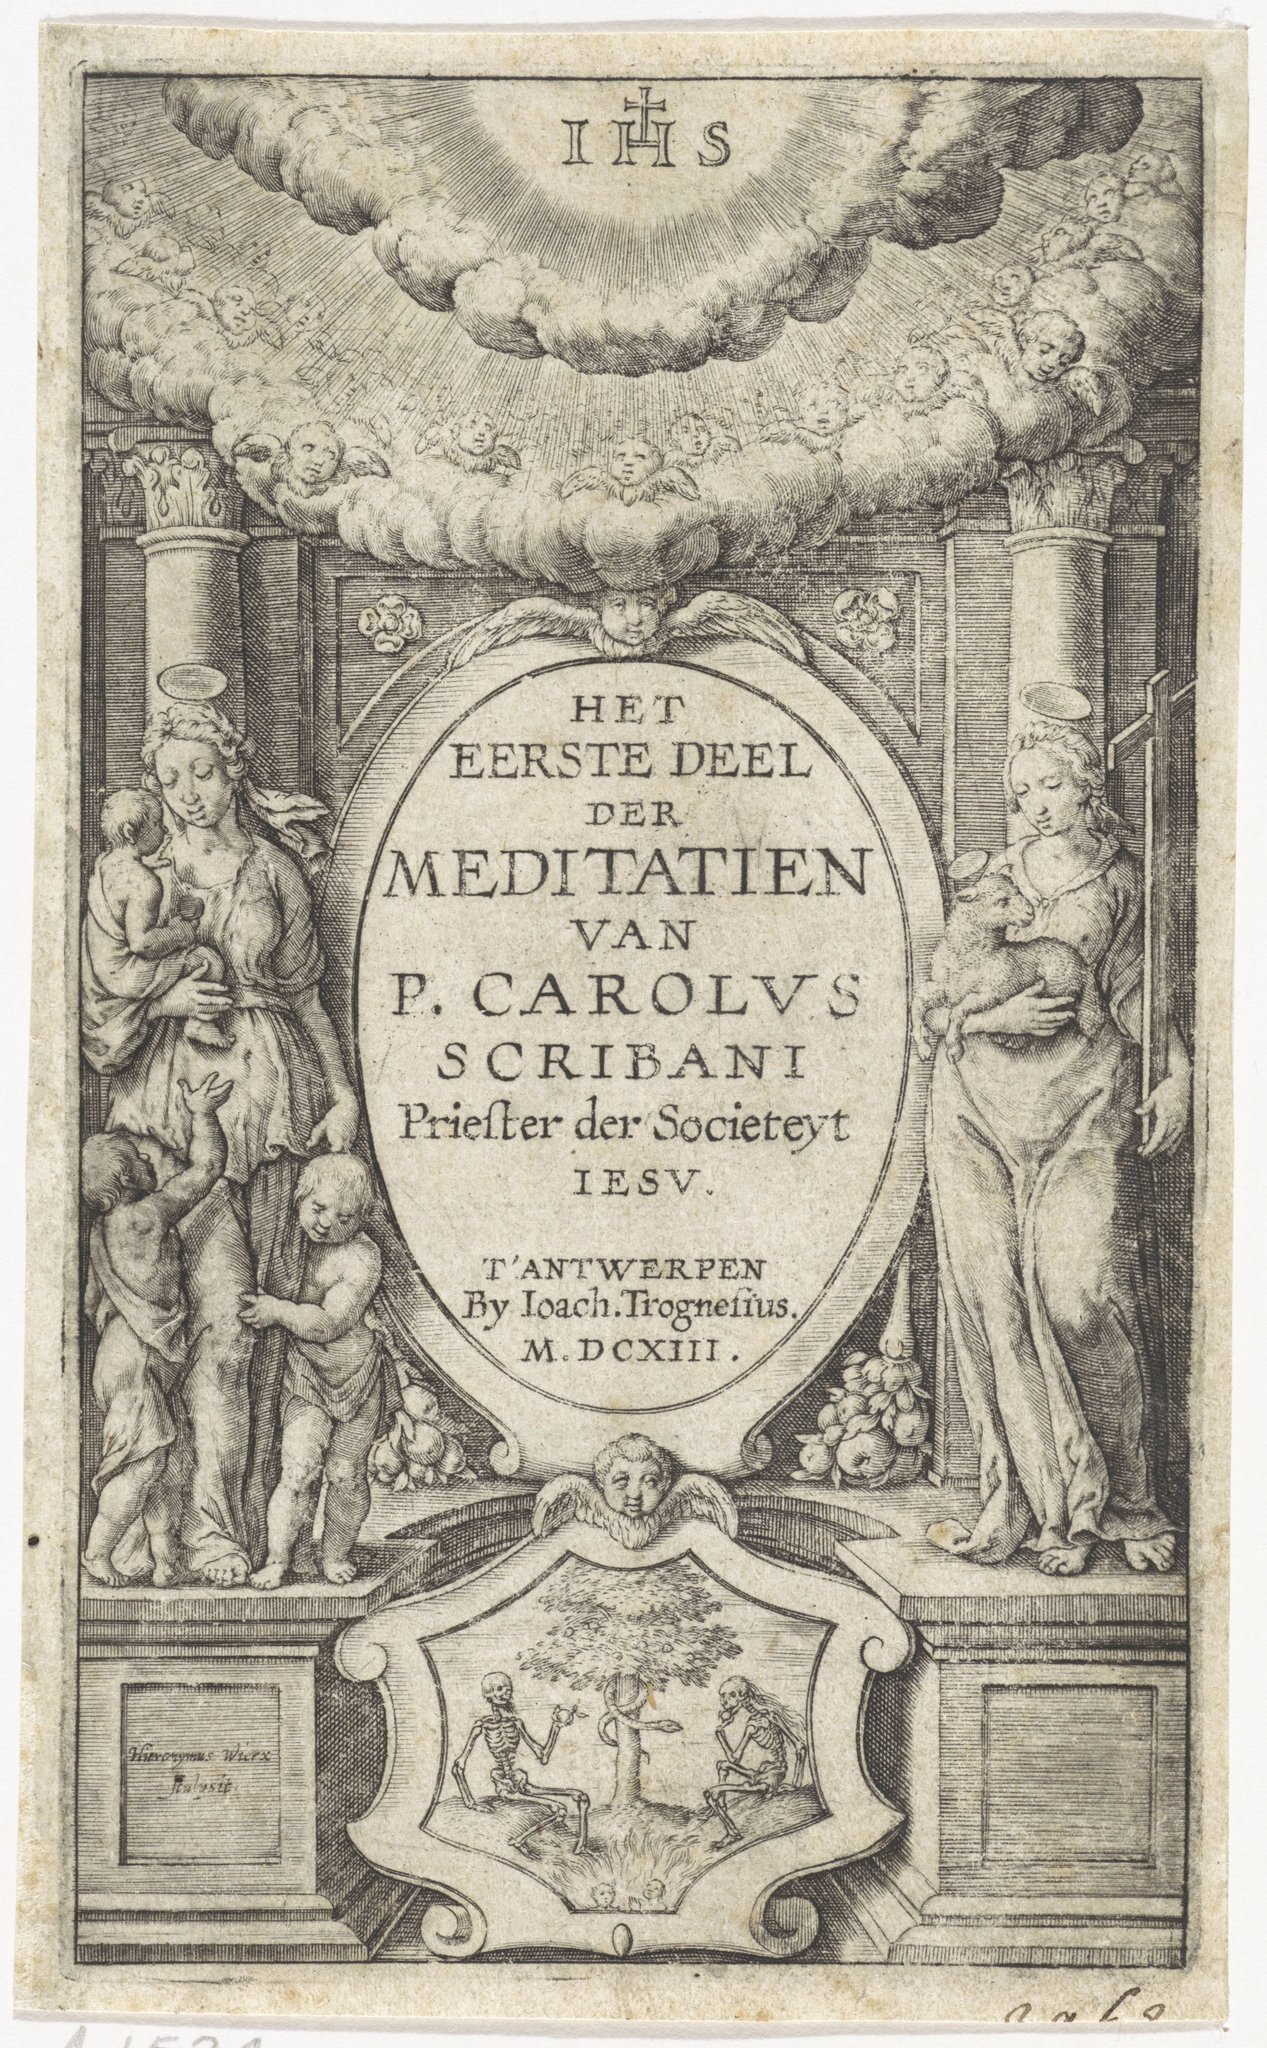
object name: print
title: Titel in omlijsting, geflankeerd door Liefde en Geloof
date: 1613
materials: paper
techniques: engraving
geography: antwerp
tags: charity, 'caritas'; 'carità' (ripa) ~ one of the three theological virtues, faith, 'fides'; 'fede', 'fede catholica', 'fede christiana', 'fede christiana catholica' (ripa) ~ one of the three theological virtues, ihs ('iesus hominum salvator') ~ symbol of christ, (human) skeleton, adam and eve (not in biblical context)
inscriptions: inscription, collector's mark: Lugt 2228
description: De titel van het boek in een ovale omlijsting. De omlijsting is gevat in een architecturale nis en wordt geflankeerd door de vrouwelijke personificaties van Liefde, met kleine kinderen, en Geloof, met kruis en lam in de handen. Onderaan in een cartouche de skeletten van Adam en Eva bij de boom der kennis van goed en kwaad. Bovenaan het monogram van Christus, omgeven door cherubijnen.